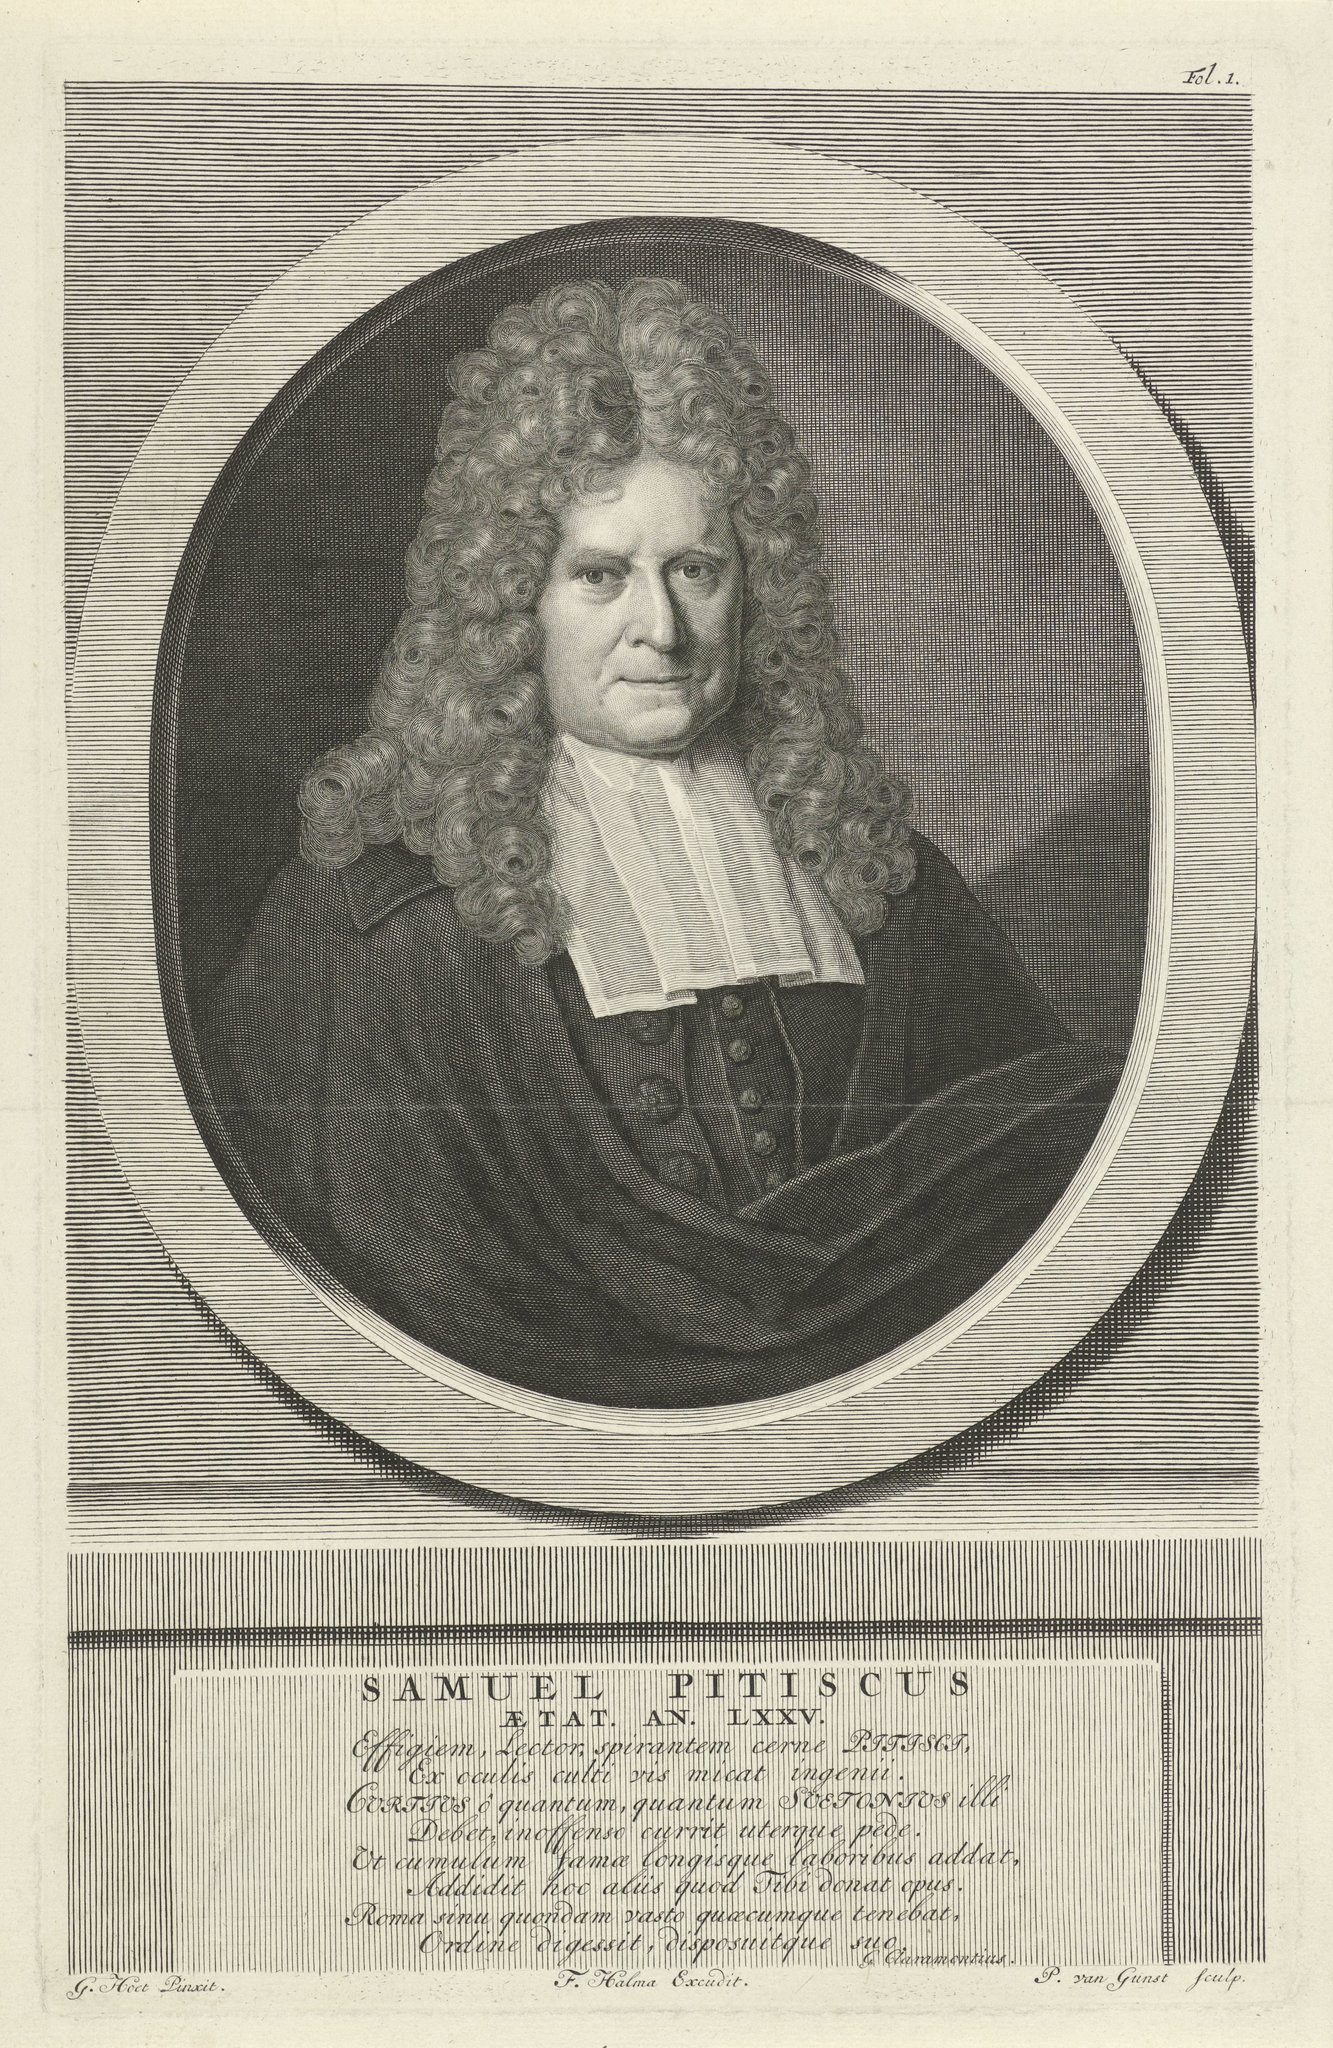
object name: print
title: Portret van Samuel Pitiscus op 75-jarige leeftijd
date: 1712-1731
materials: paper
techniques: engraving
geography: amsterdam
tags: samuel pitiscus, historical persons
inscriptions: collector's mark: Lugt 2228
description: Samuel Pitiscus, een klassieke geleerde uit Zutphen, op zijn 75-jarige leeftijd. De prent heeft een Latijns onderschrift.